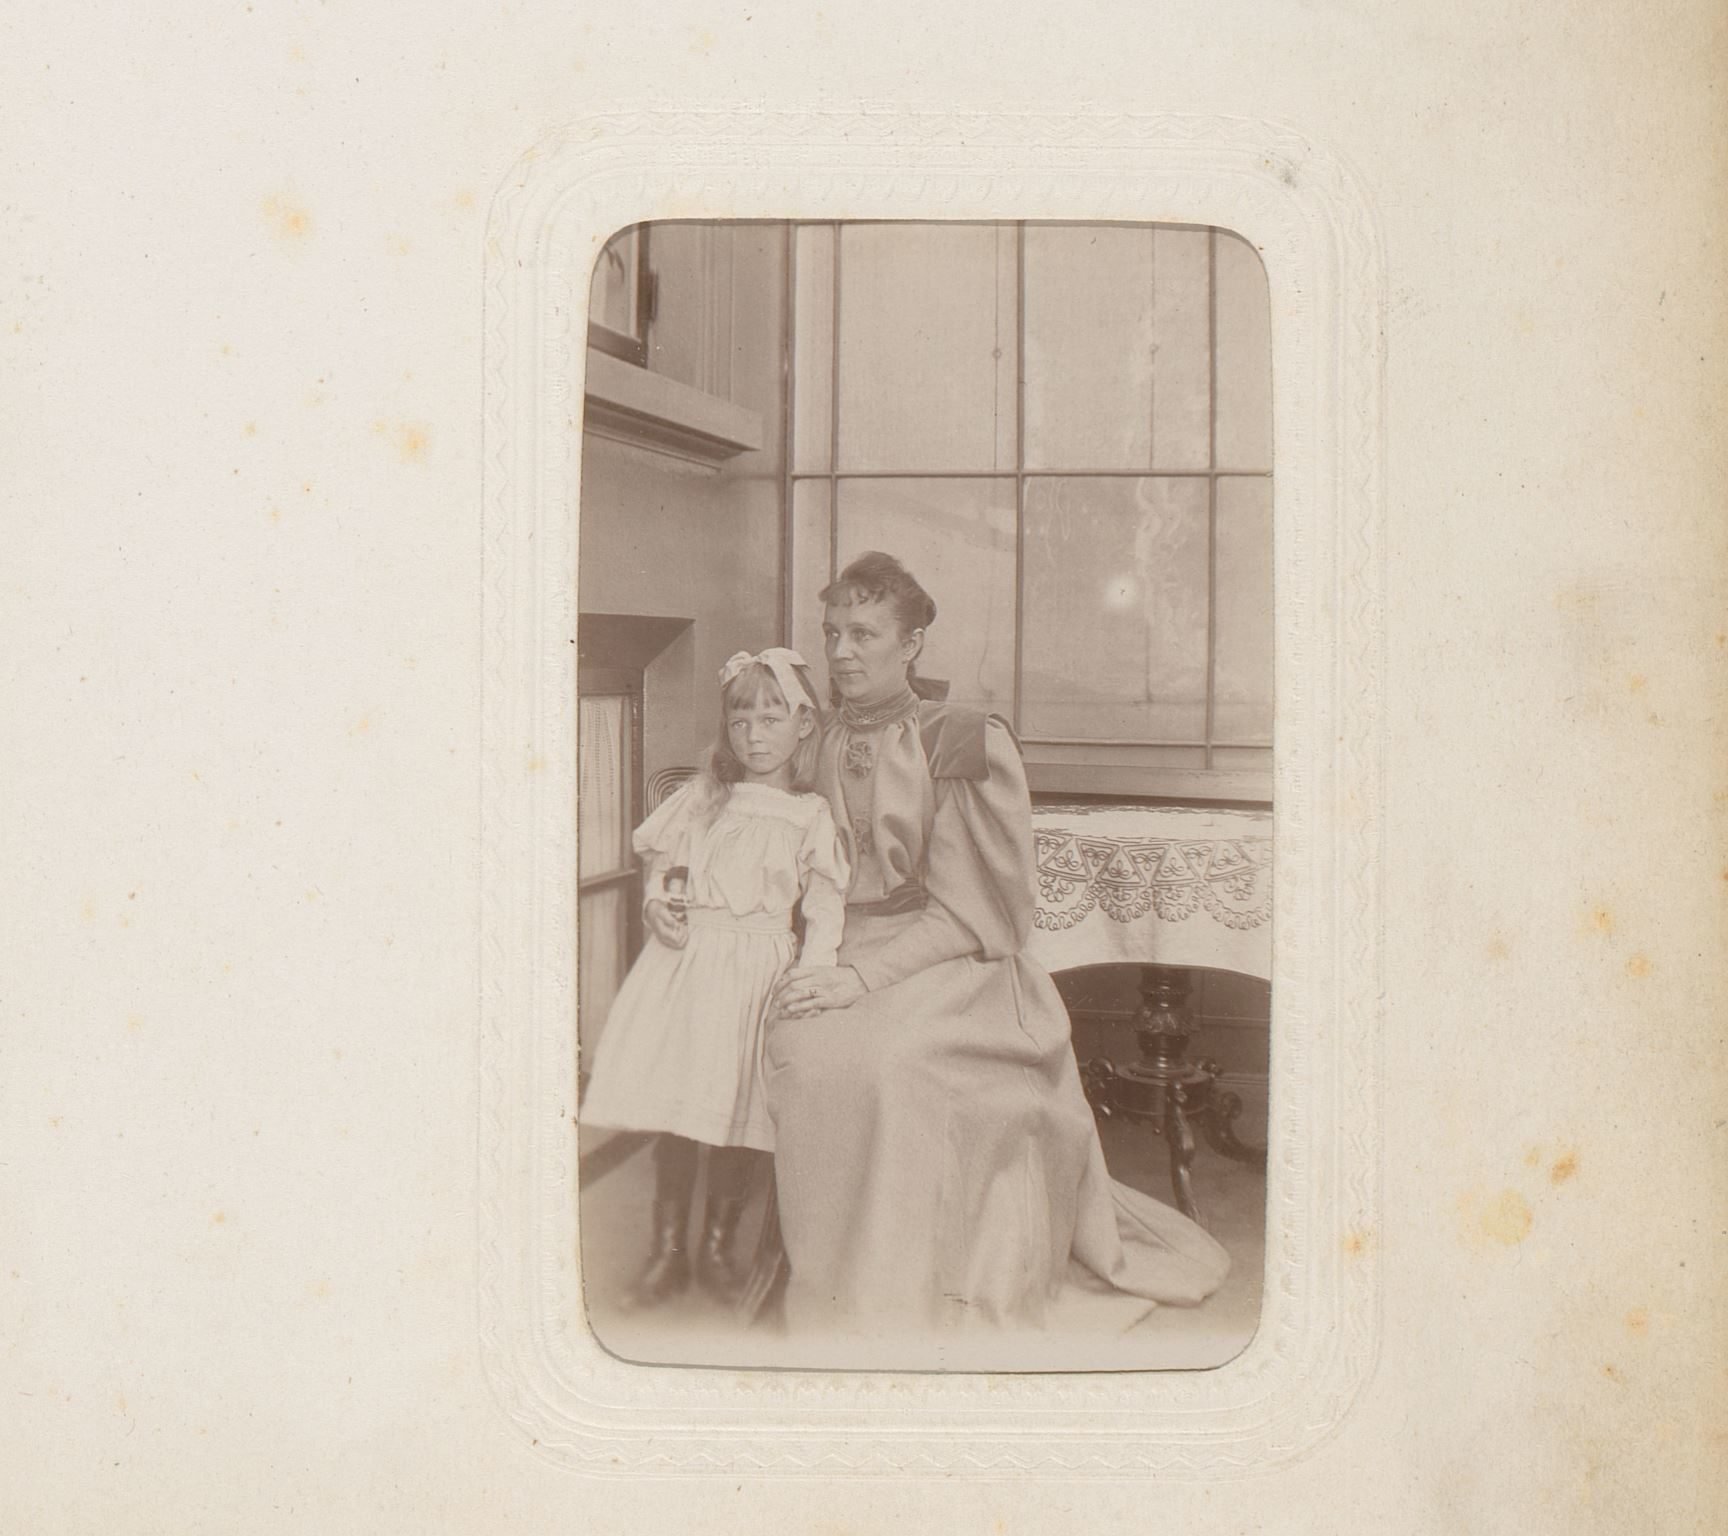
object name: photograph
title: Portret van een zittende vrouw en een staand meisje in een interieur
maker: Anonymous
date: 1895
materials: cardboard, photographic support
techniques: collodion silver print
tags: sitting figure - aa - female human figure, historical persons - bb - woman, girl (child between toddler and youth), interior of the house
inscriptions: date: ‘1. 9. 95.’